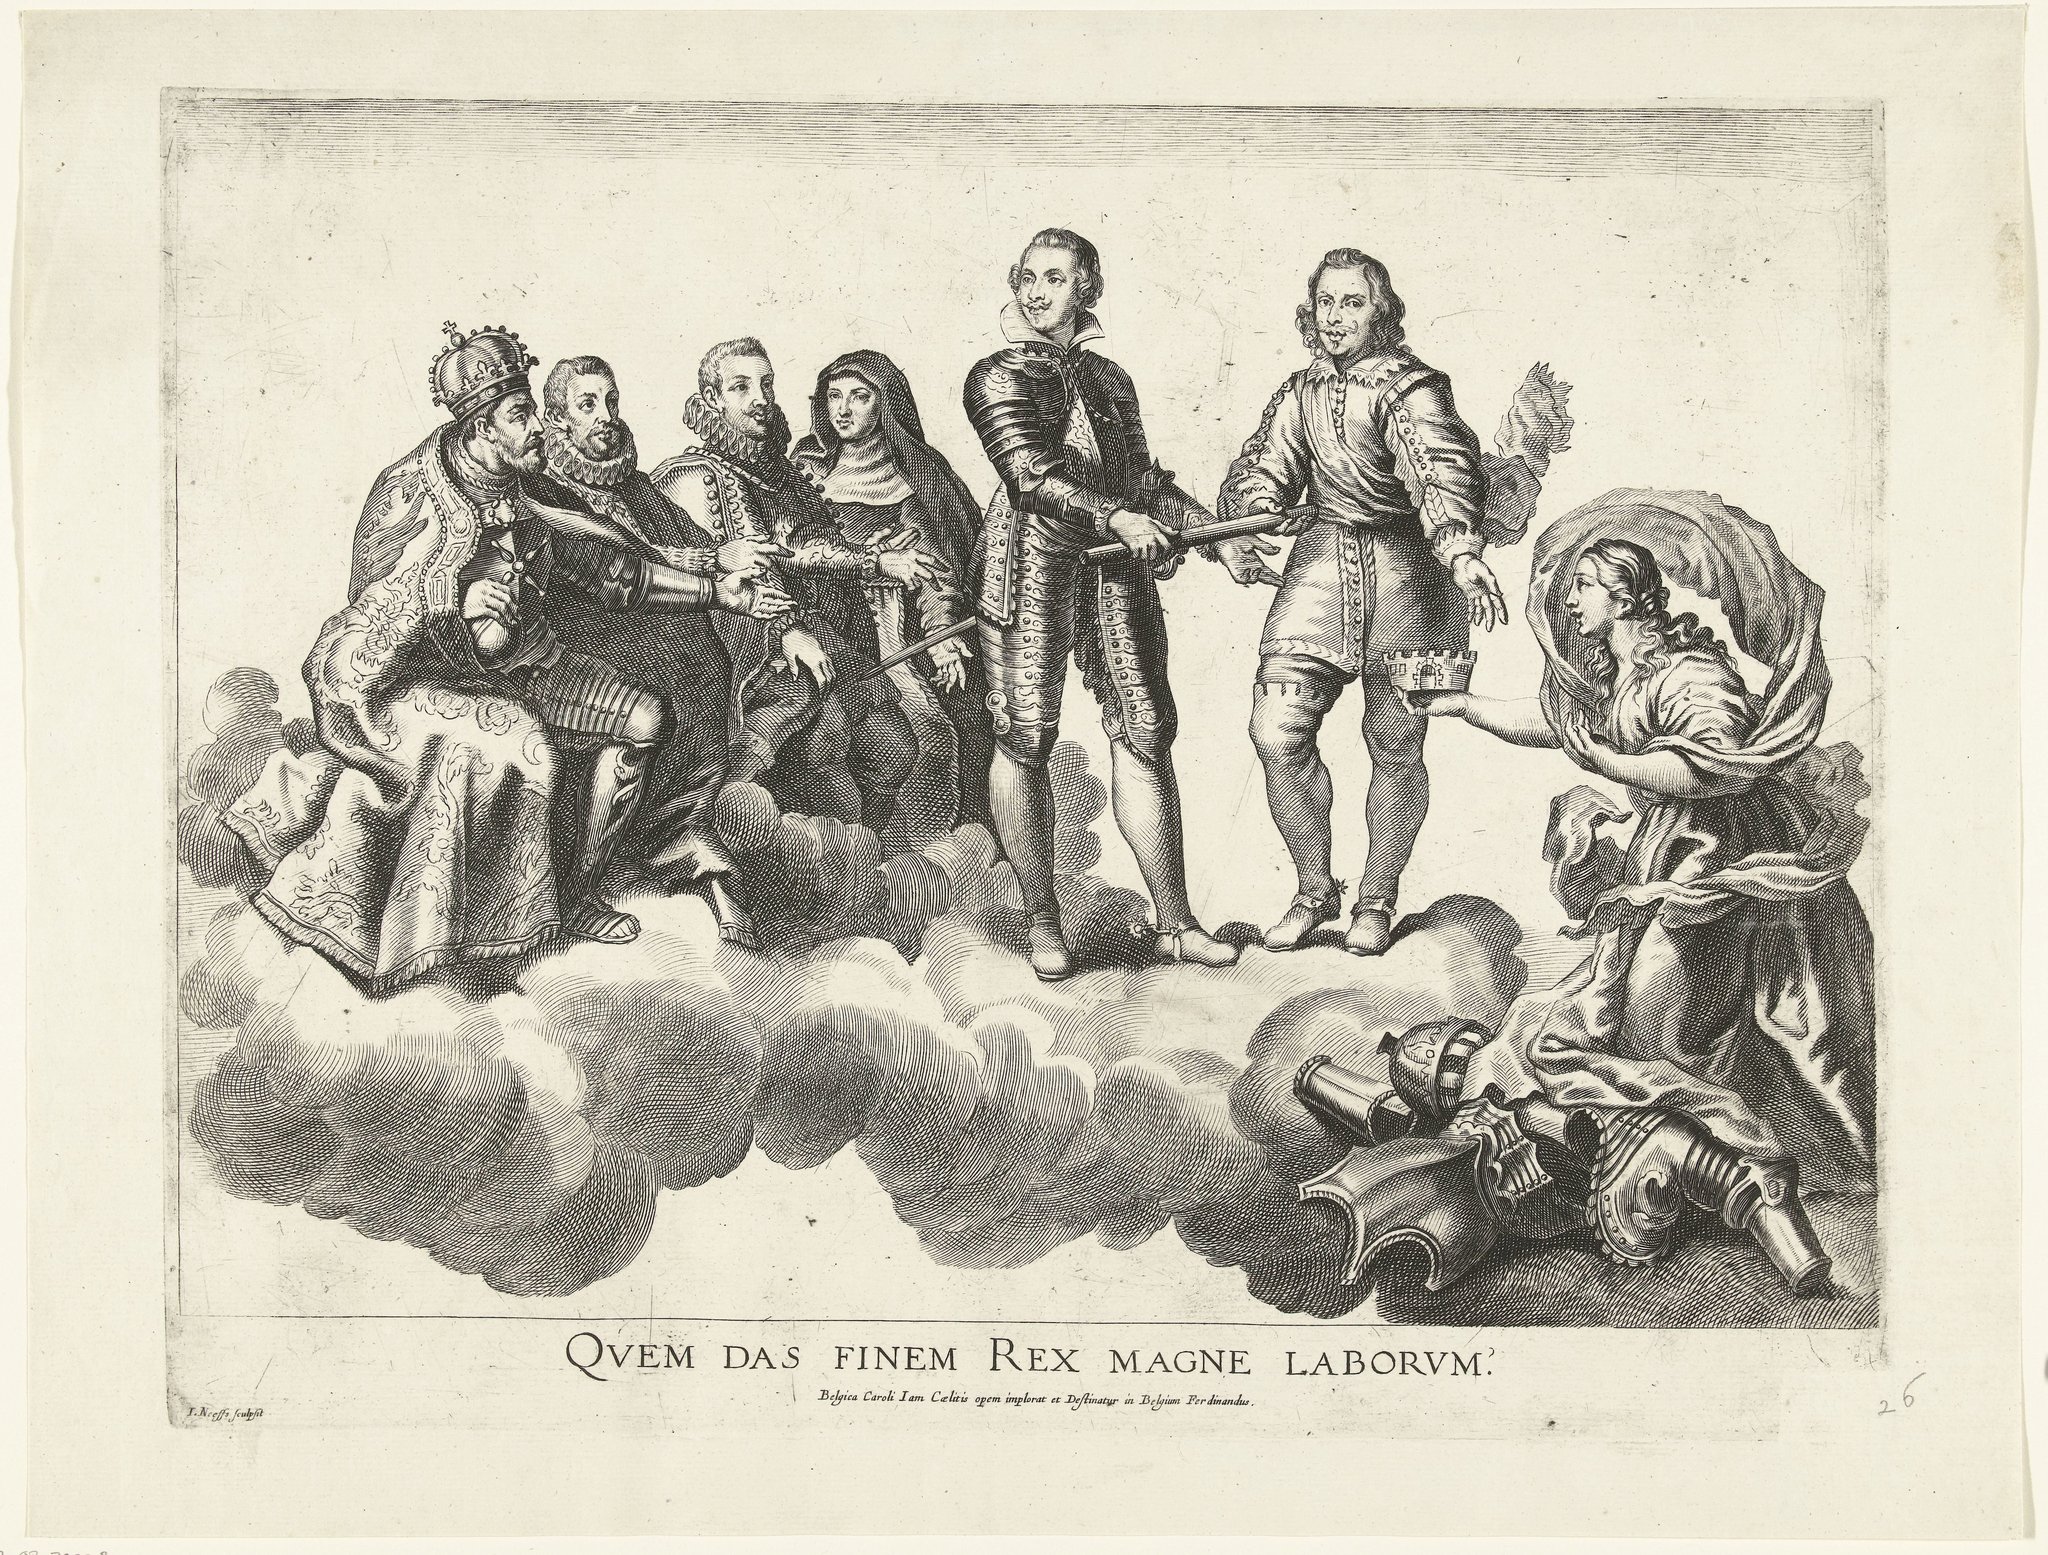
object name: print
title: Arcus Carolini suprema tabula. Belgica Caroli iam caelitis opem implorat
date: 1635-1636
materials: paper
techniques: engraving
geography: southern netherlands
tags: philip ii of spain, filips iv (koning van spanje), infante van spanje isabella clara eugenia, charles v (holy roman emperor and king of spain), filips iii (koning van spanje), landvoogd der zuidelijke nederlanden ferdinand van oostenrijk, personifications of countries, nations, states, districts, etc., triumphal arch, ghent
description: De smeekbede van Belgica. De maagd van de Zuidelijke Nederlanden knielend met de landskroon vraag Karel V om Ferdinand het land te laten besturen. Scène in de hemel, Karel V zit met de vorsten Filips II, Filips III en Isabella Clara Eugenia. Filips IV overhandigt Ferdinand een commandostaf. Voorstelling bovenop de voorzijde van de triomfpoort Arcus Caroli op de Vrijdagmarkt. Blad nr. 26 in een geheel van 42 platen die de uitgave van de beschrijving van de intocht van de Kardinaal Infant Ferdinand van Oostenrijk te Gent op 28 januari 1635 als de nieuwe landvoogd voor de Spaanse Nederlanden illustreren.